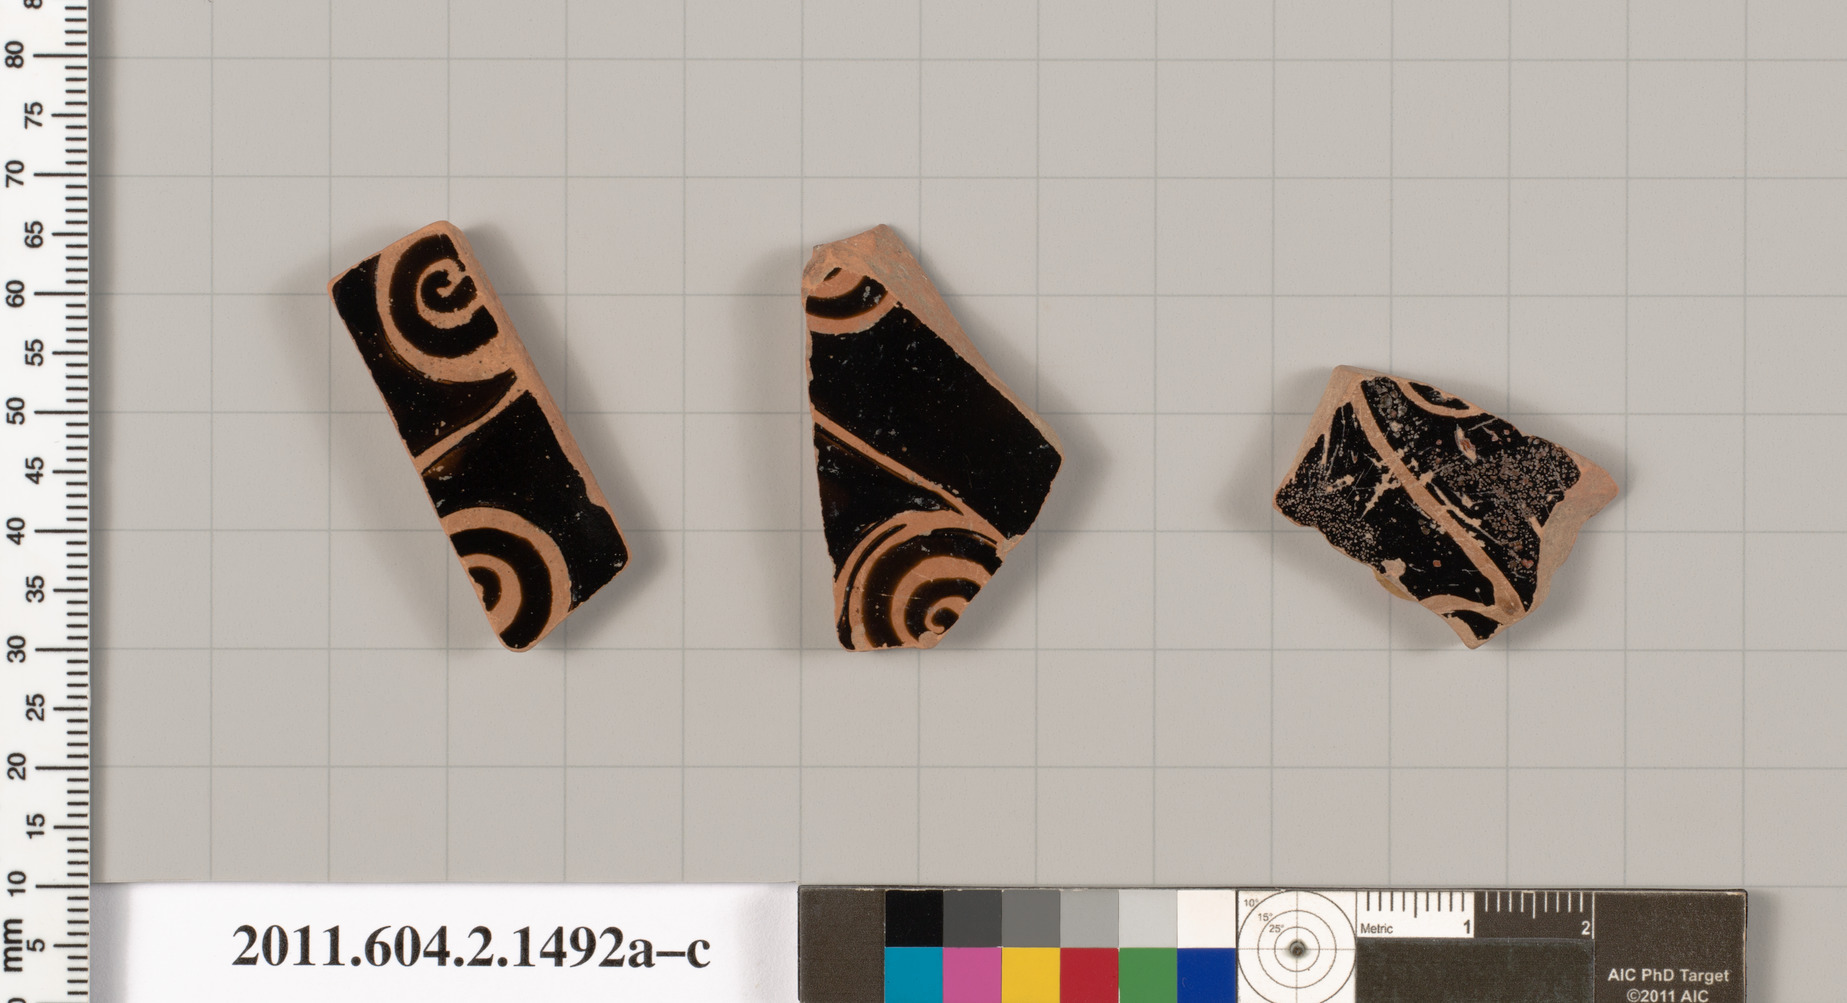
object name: skyphos fragment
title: Terracotta fragments of skyphoi (deep drinking cups)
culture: greek, attic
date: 475-440 BCE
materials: terracotta